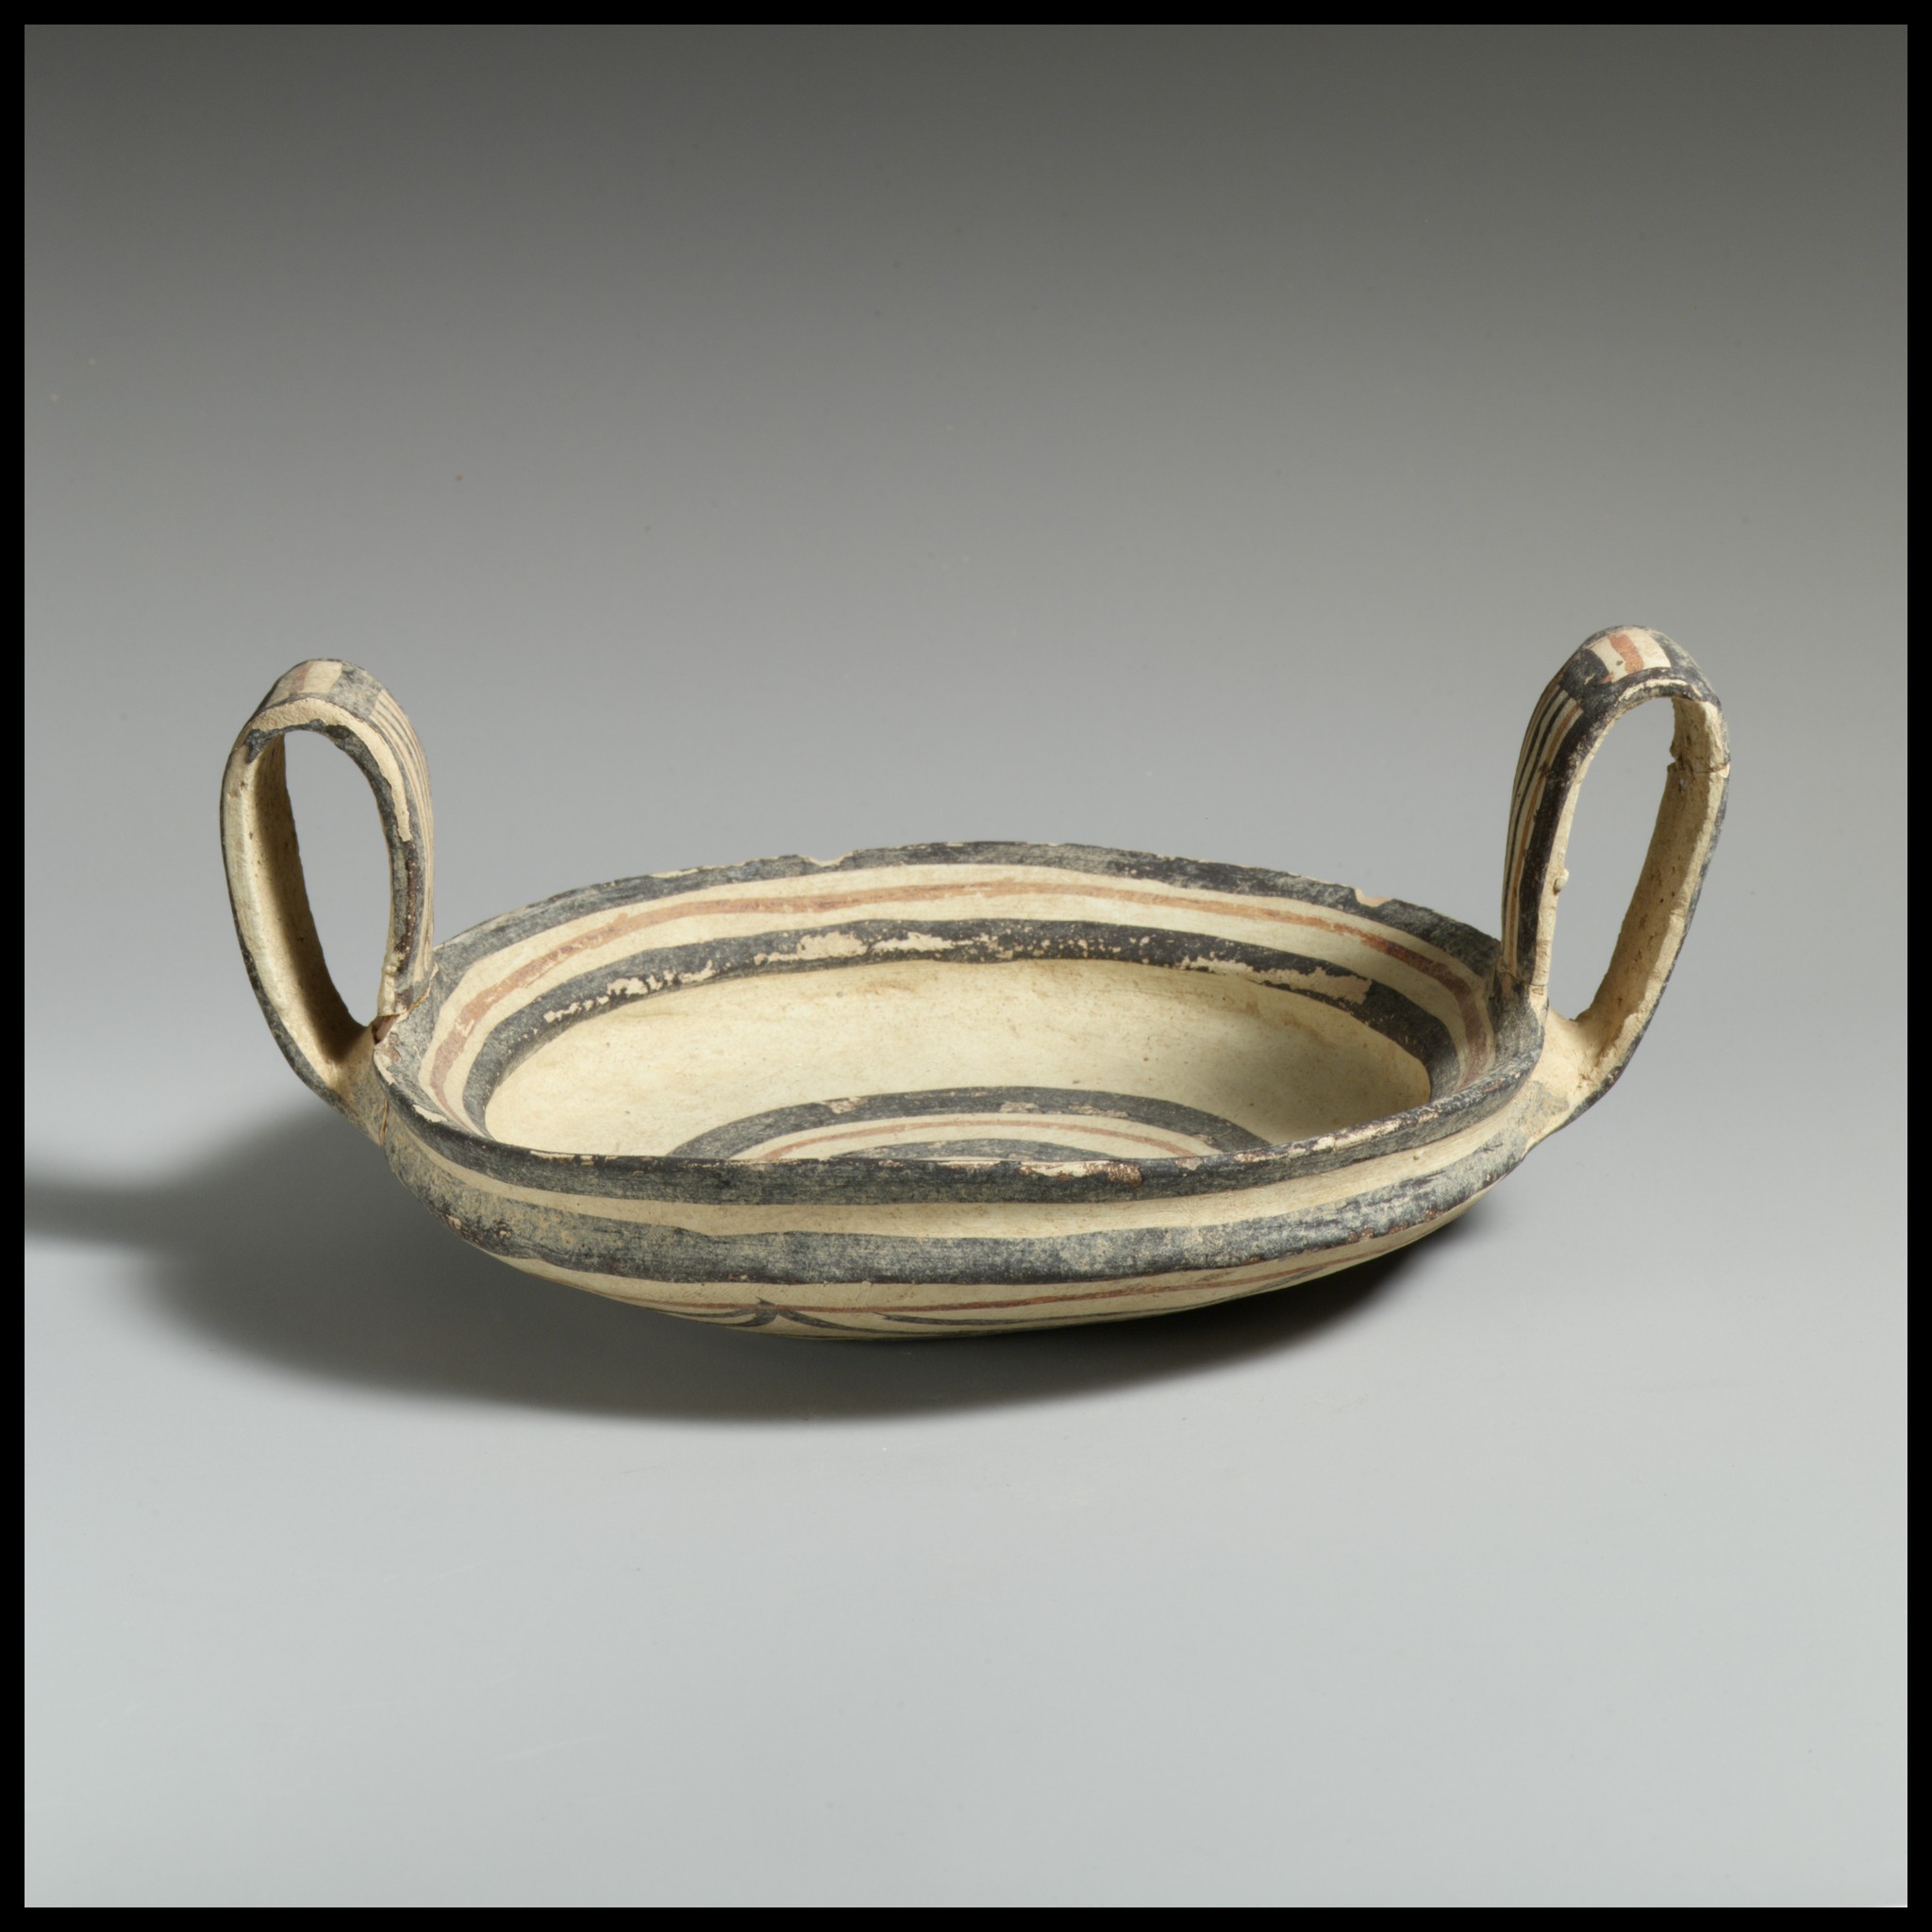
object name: bowl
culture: italic, daunian or south italian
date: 550-450 BCE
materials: terracotta